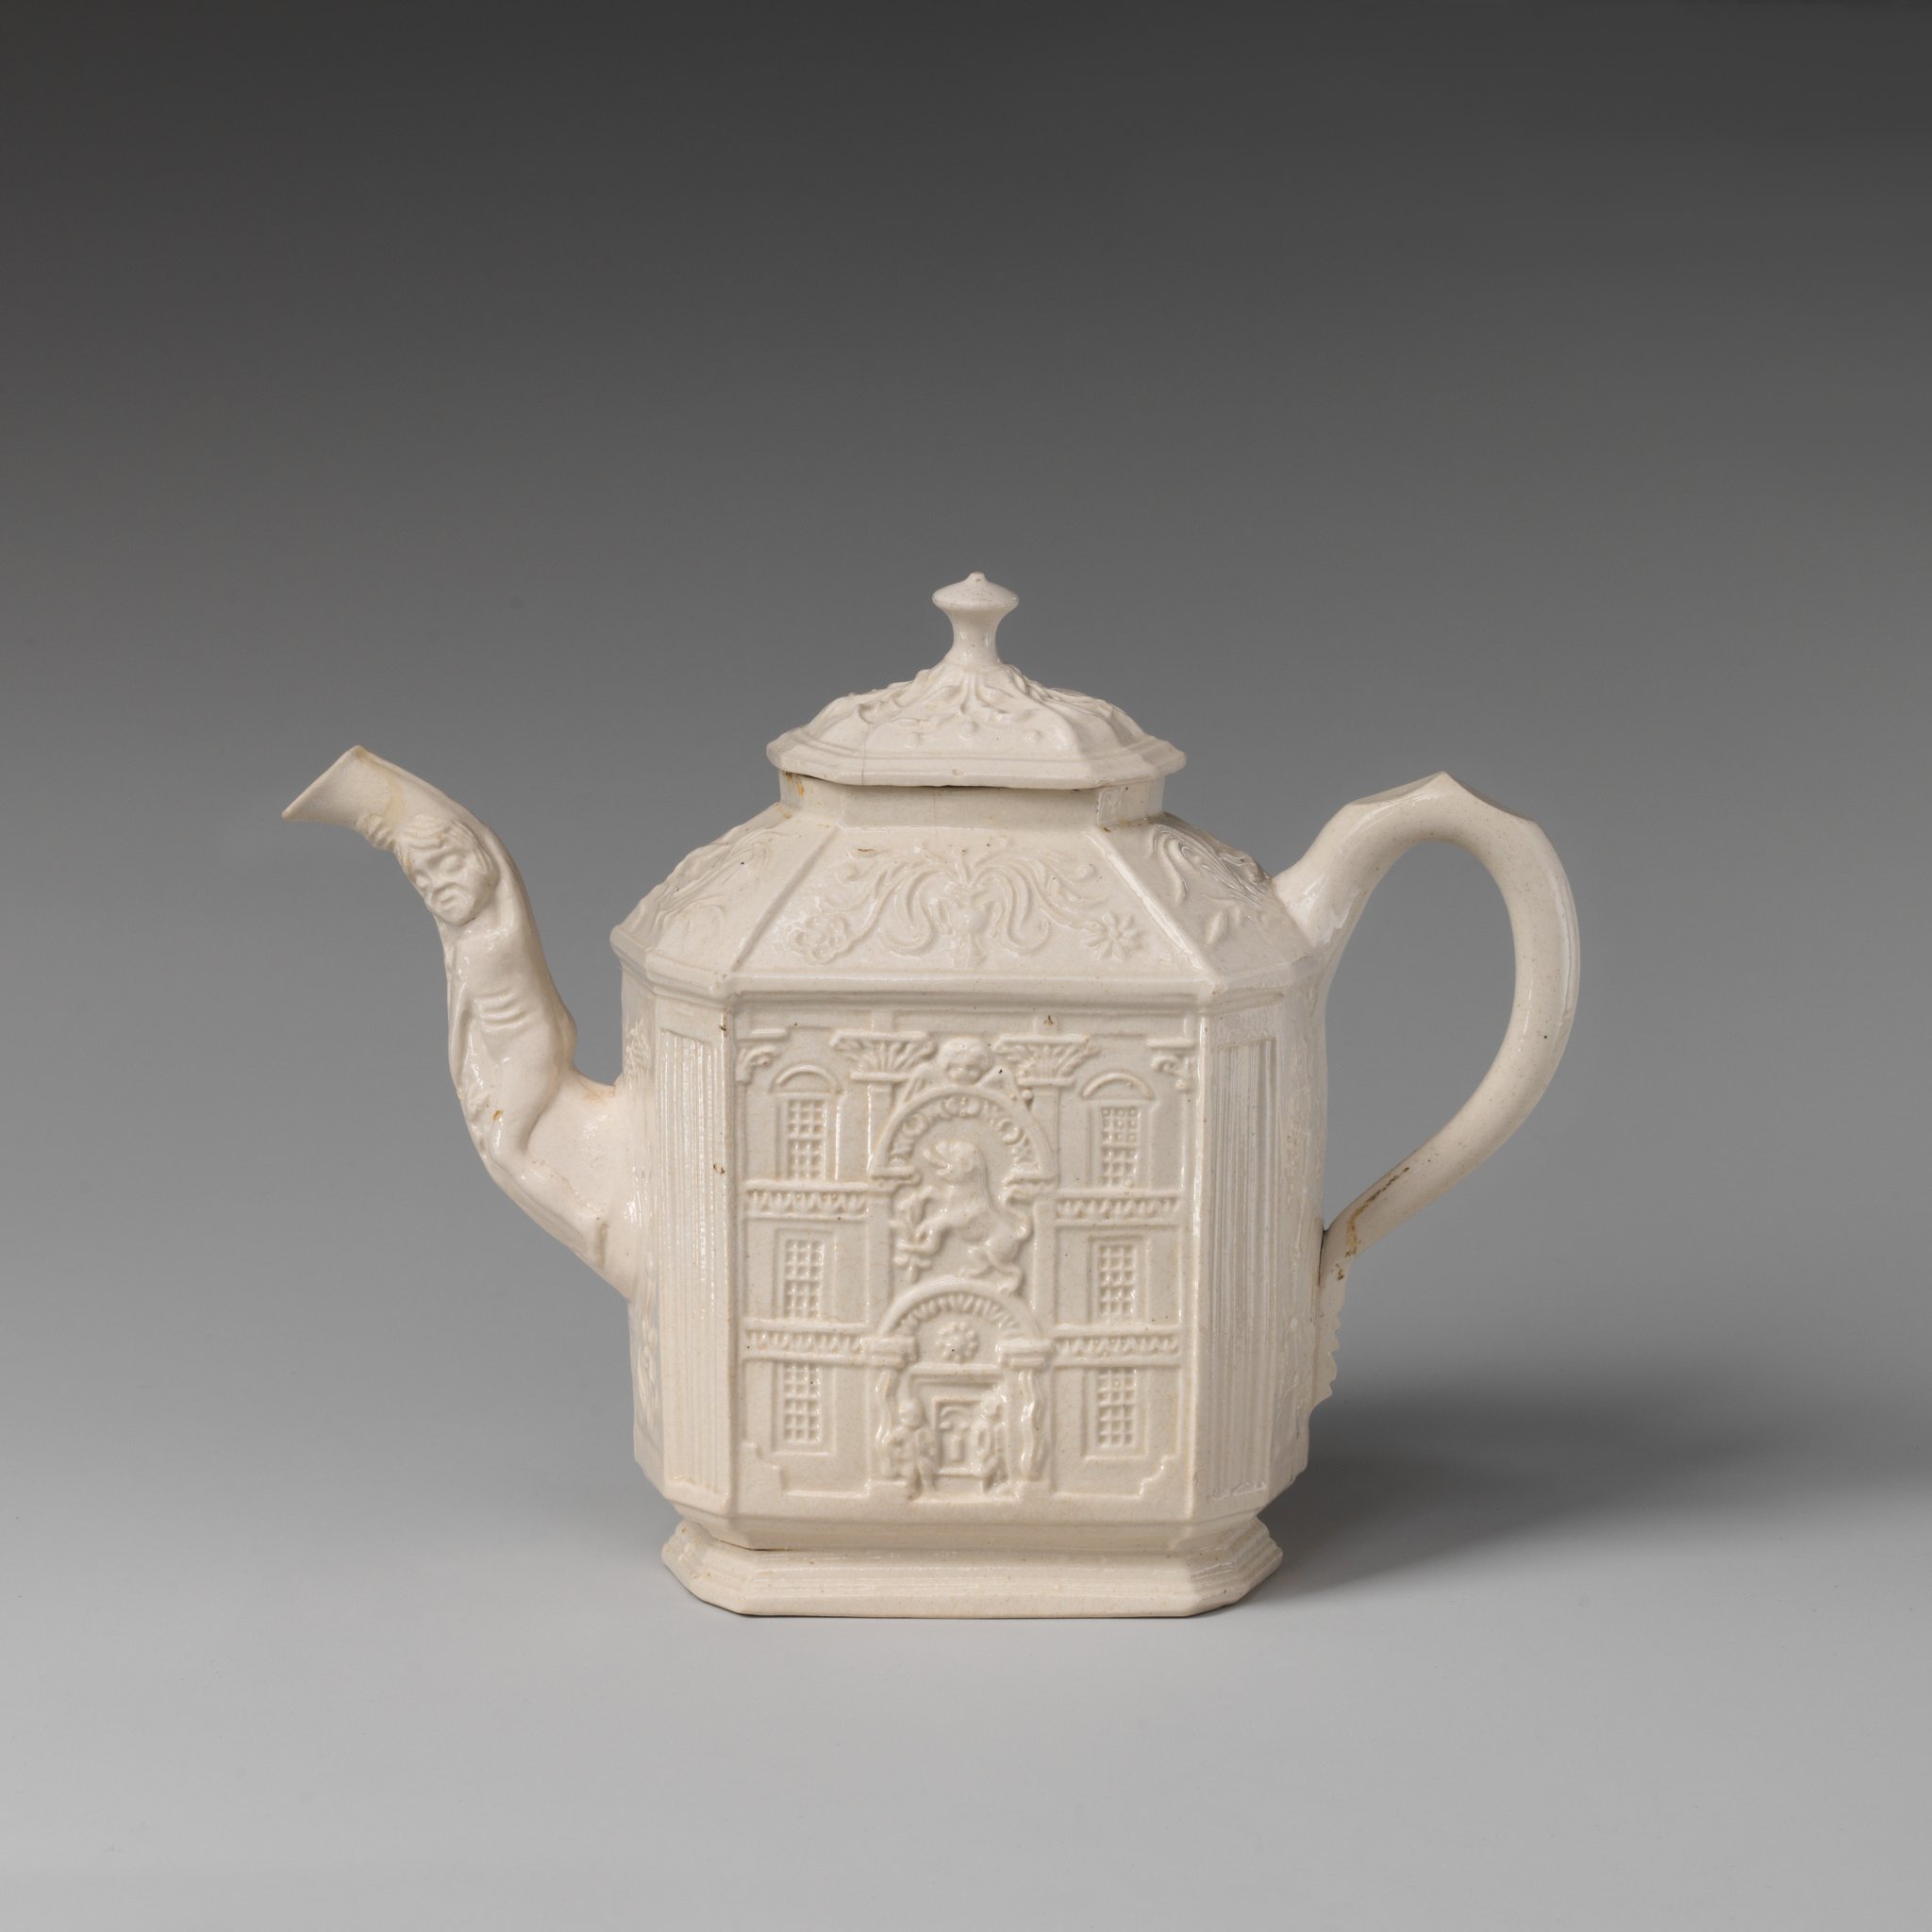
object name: teapot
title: Teapot in the form of a house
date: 1745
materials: stoneware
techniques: salt glaze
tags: human figures,animals,faces